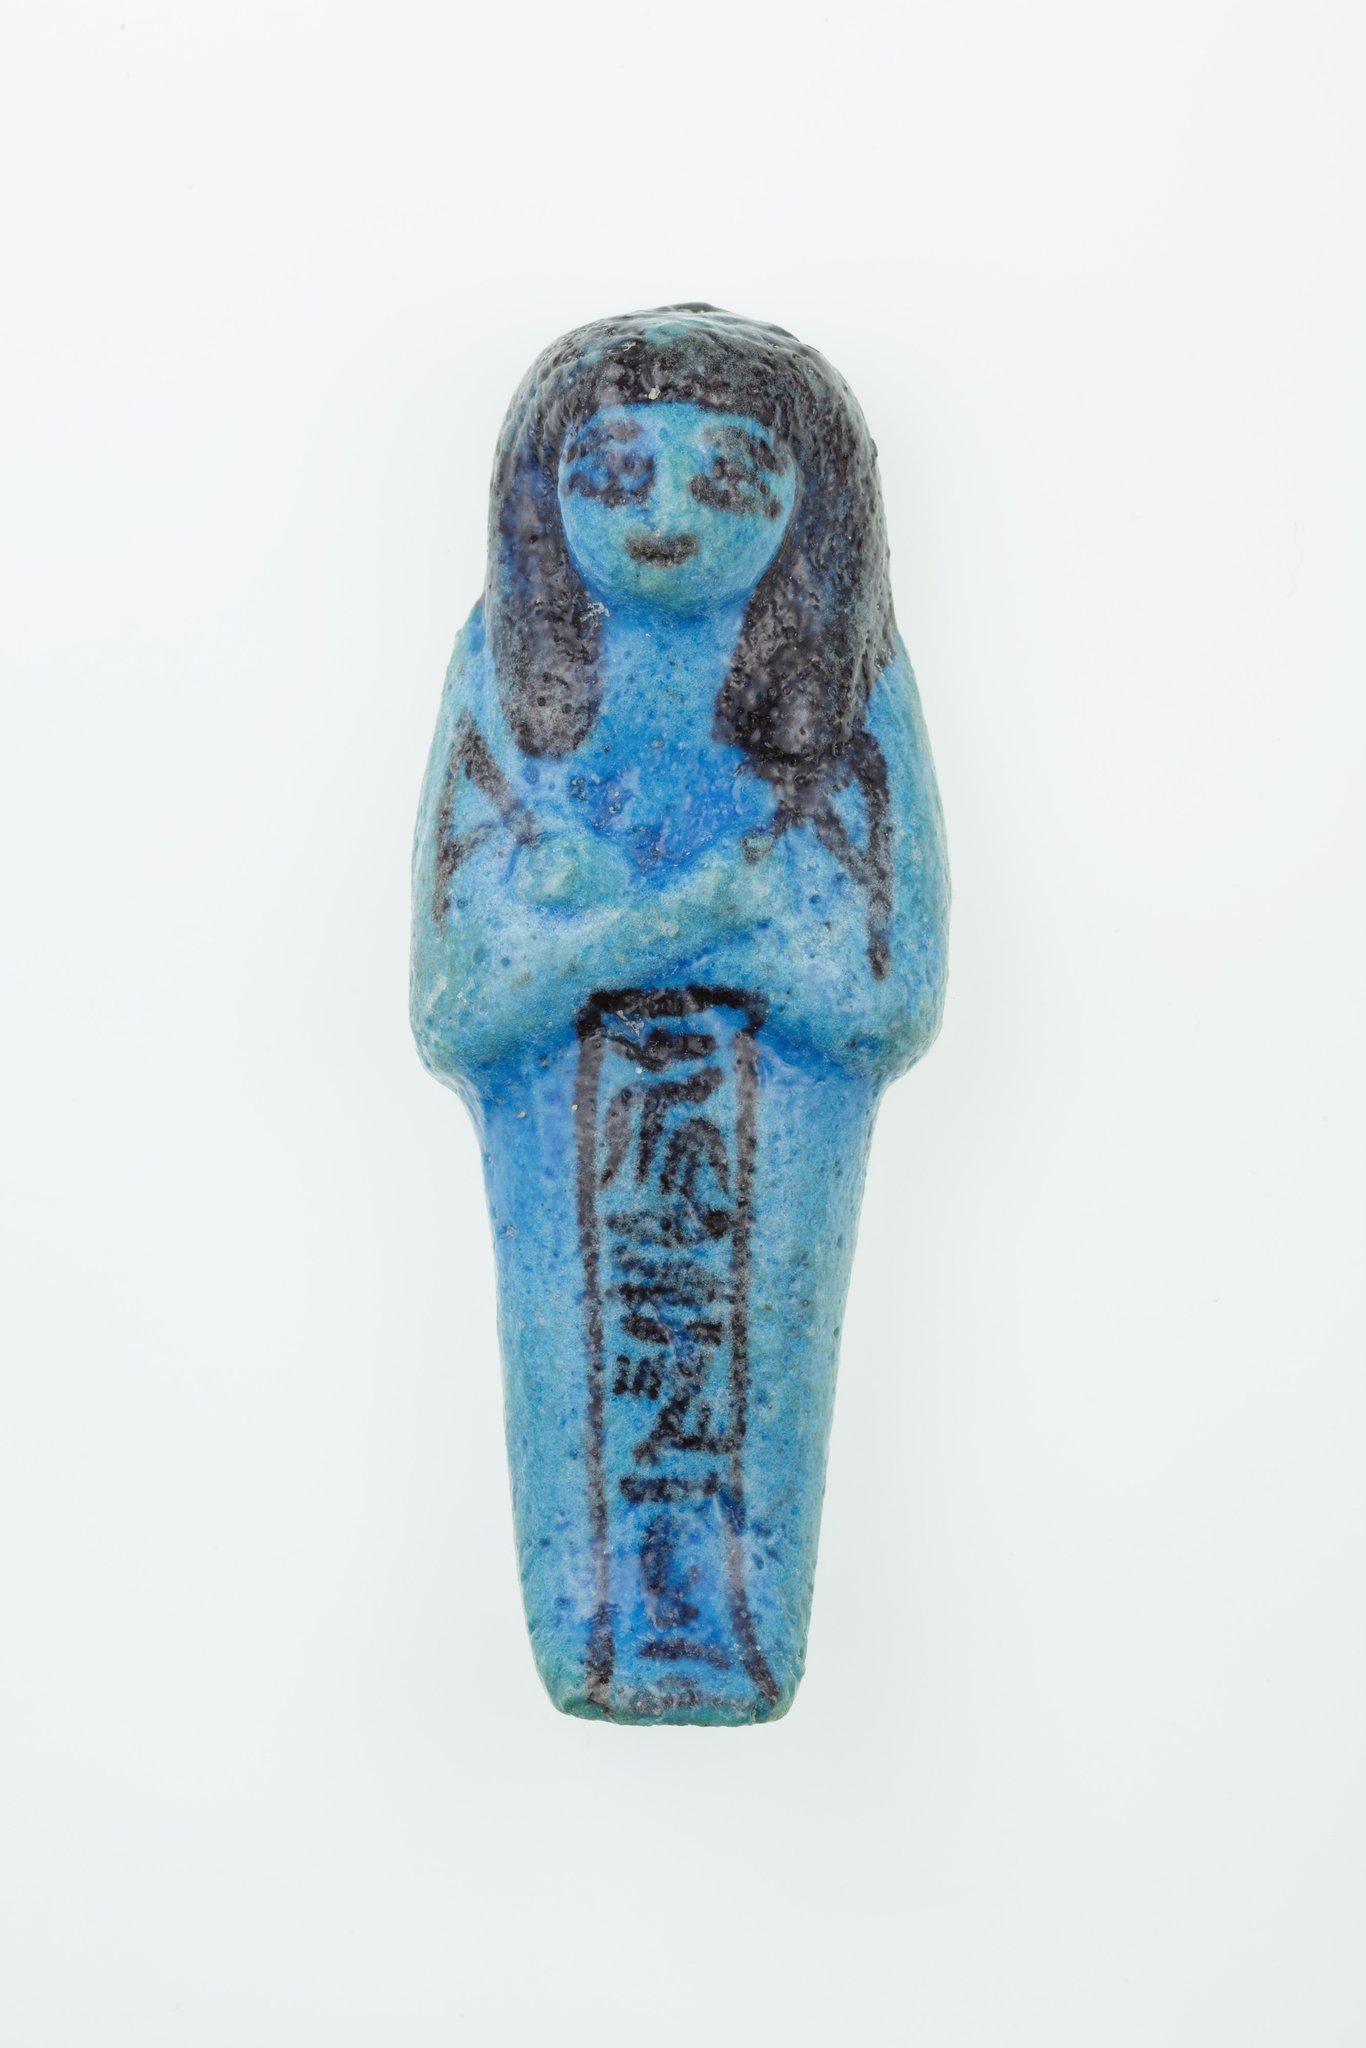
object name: shabti, worker, nauny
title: Worker Shabti of Nauny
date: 1050 BCE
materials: faience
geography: egypt